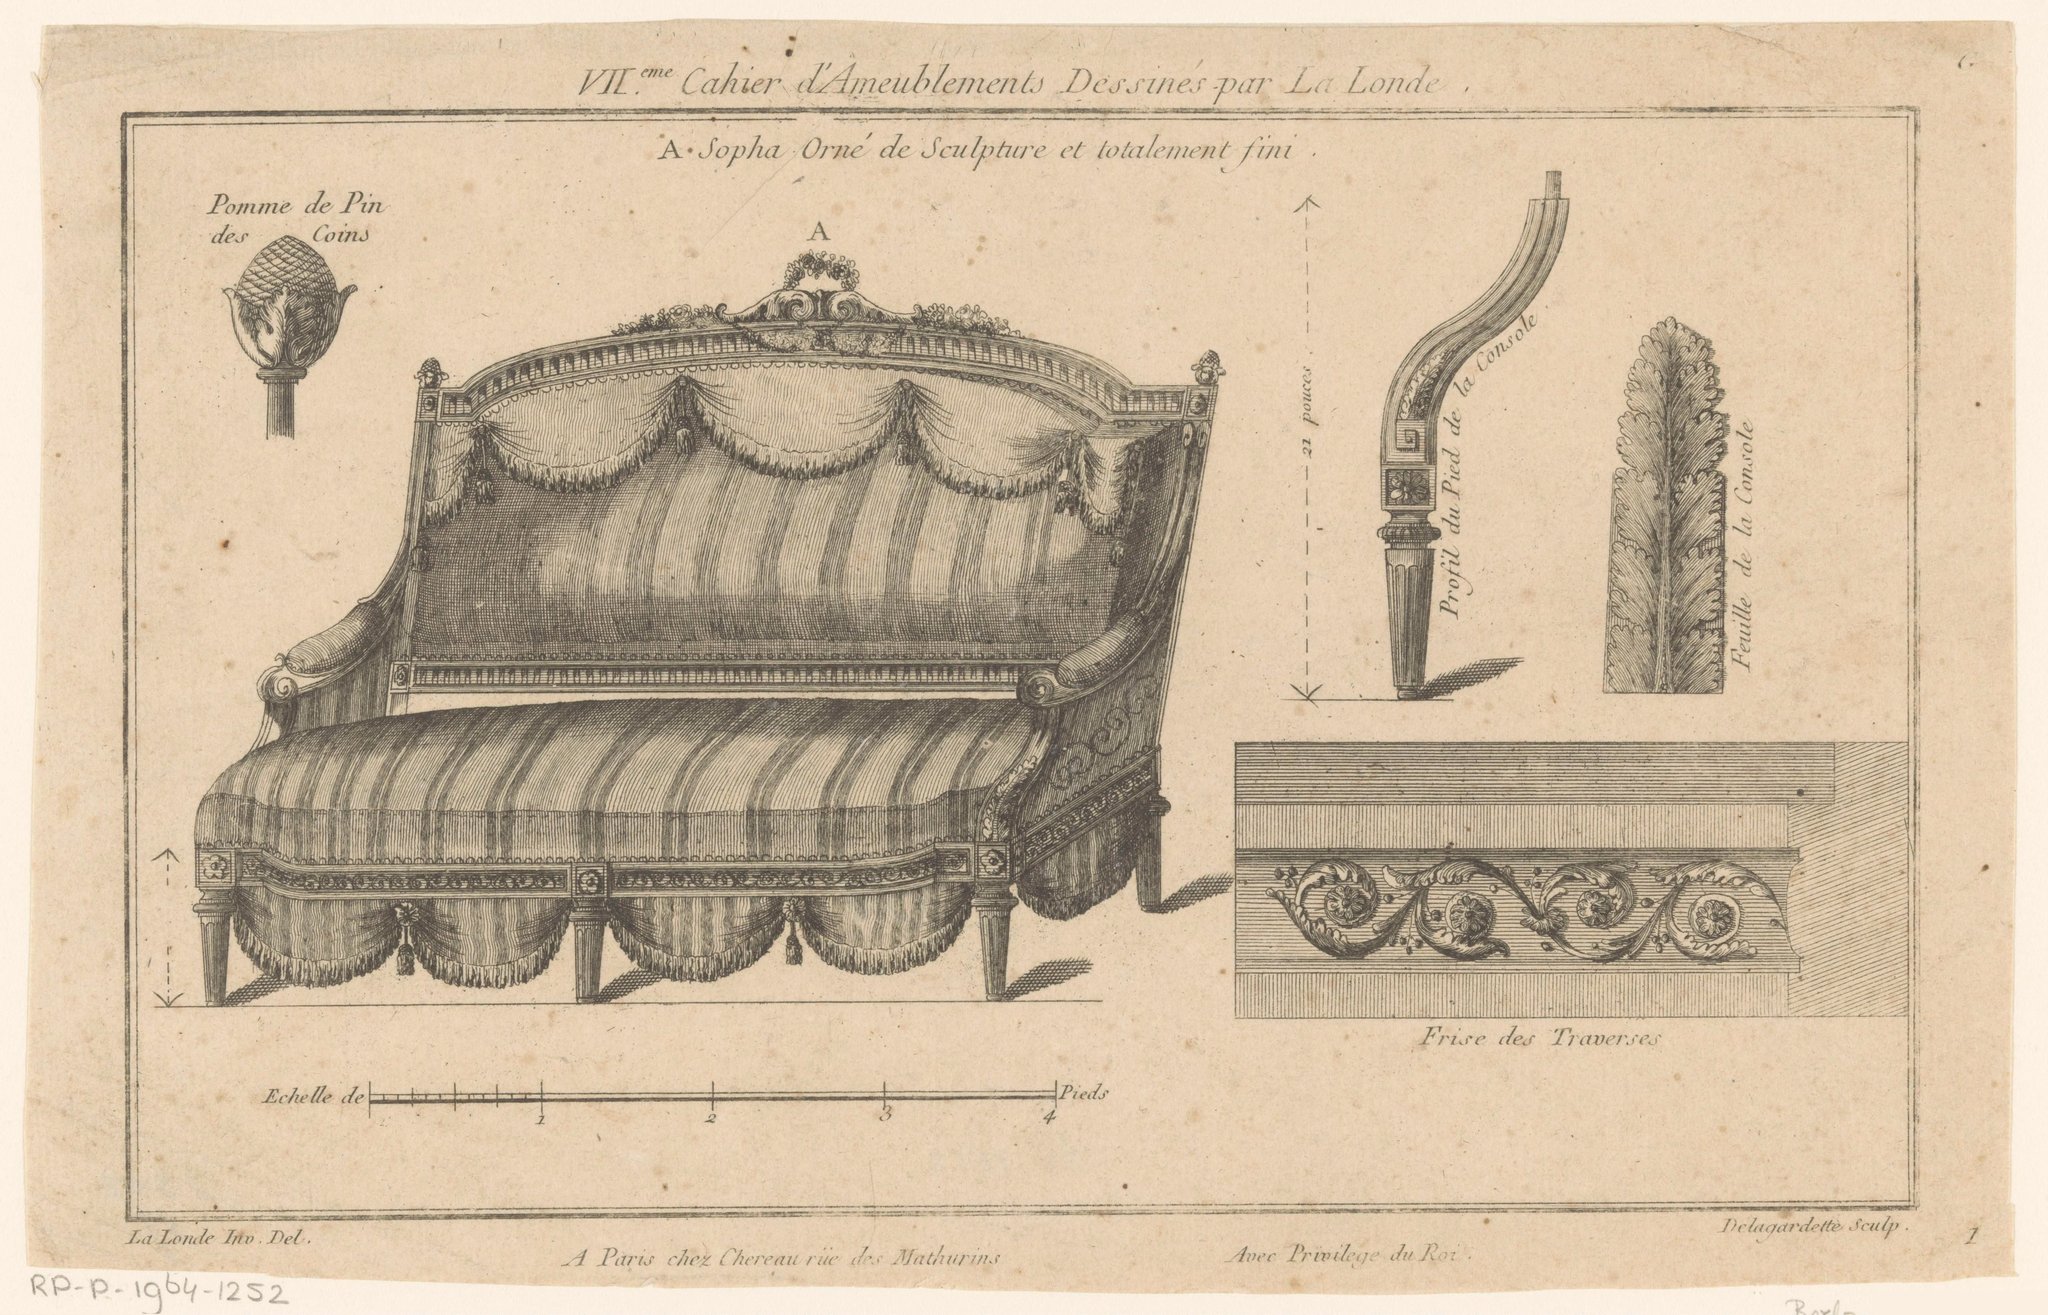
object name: print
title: Sopha Orné de Sculpture et totalement fini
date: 1784-1785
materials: paper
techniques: etching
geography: paris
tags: couch, sofa, settee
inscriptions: collector's mark: Lugt 2228, collector's mark: Lugt 2760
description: Vooraanzicht van een geornamenteerde sofa met gestreepte bekleding. Links en rechts details van de ornamenten op het meubel.